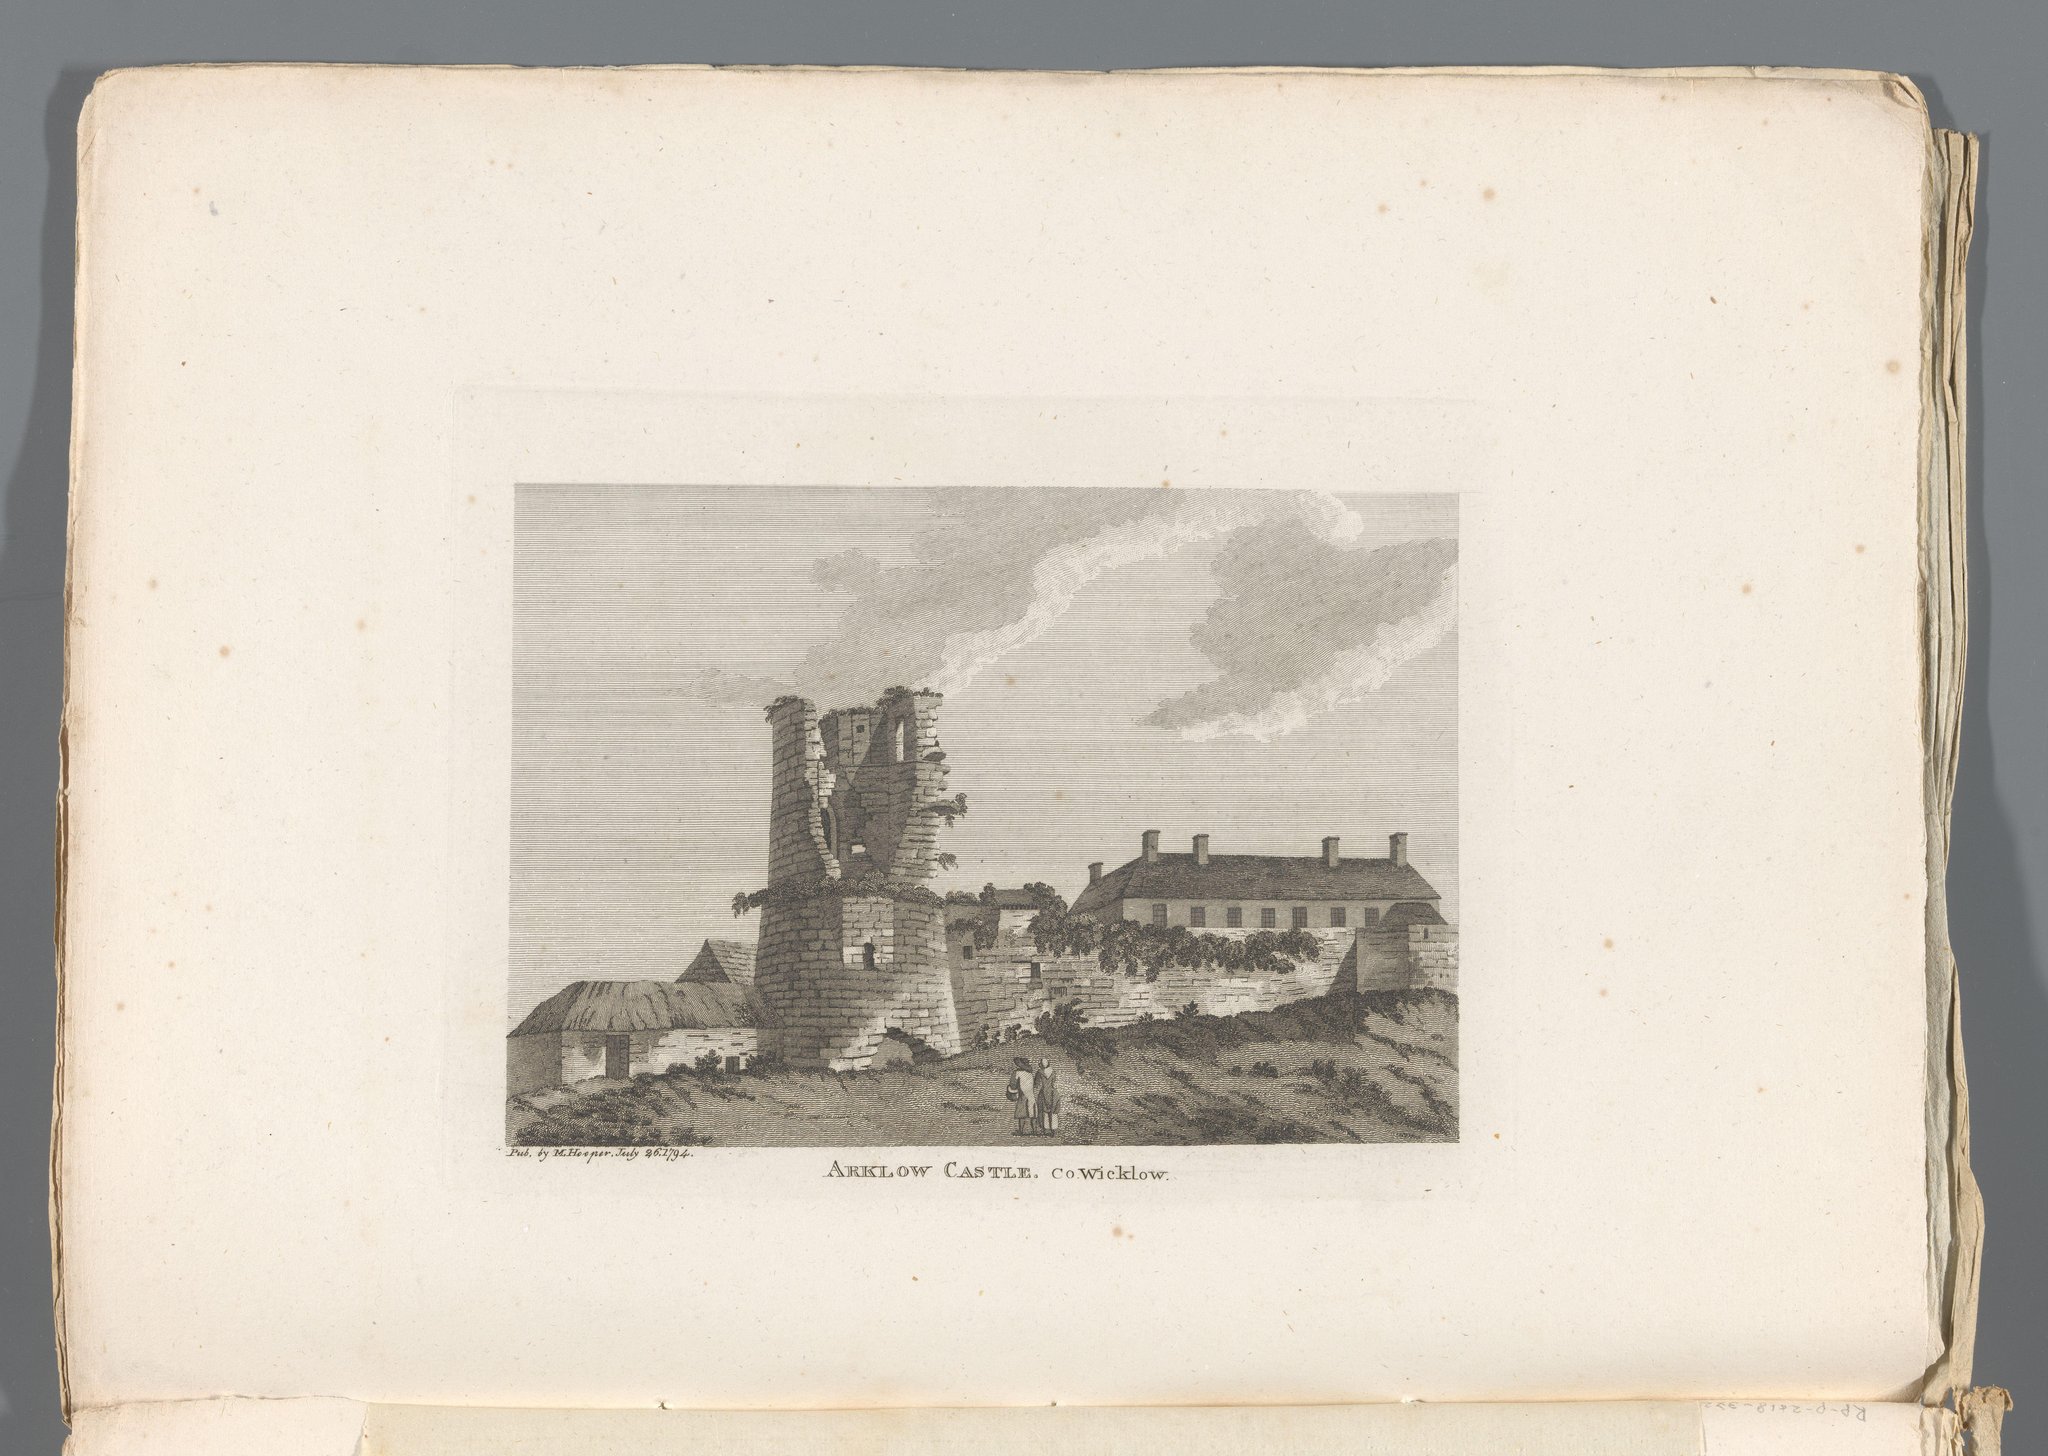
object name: book illustration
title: Gezicht op de ruïne van Arklow Castle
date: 1794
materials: paper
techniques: etching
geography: london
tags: landscape with ruins, landscape with tower or castle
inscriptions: date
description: Prent verschenen in: Grose, Francis. The antiquities of Ireland. Londen: S. Hooper, 1795, dl. 2.